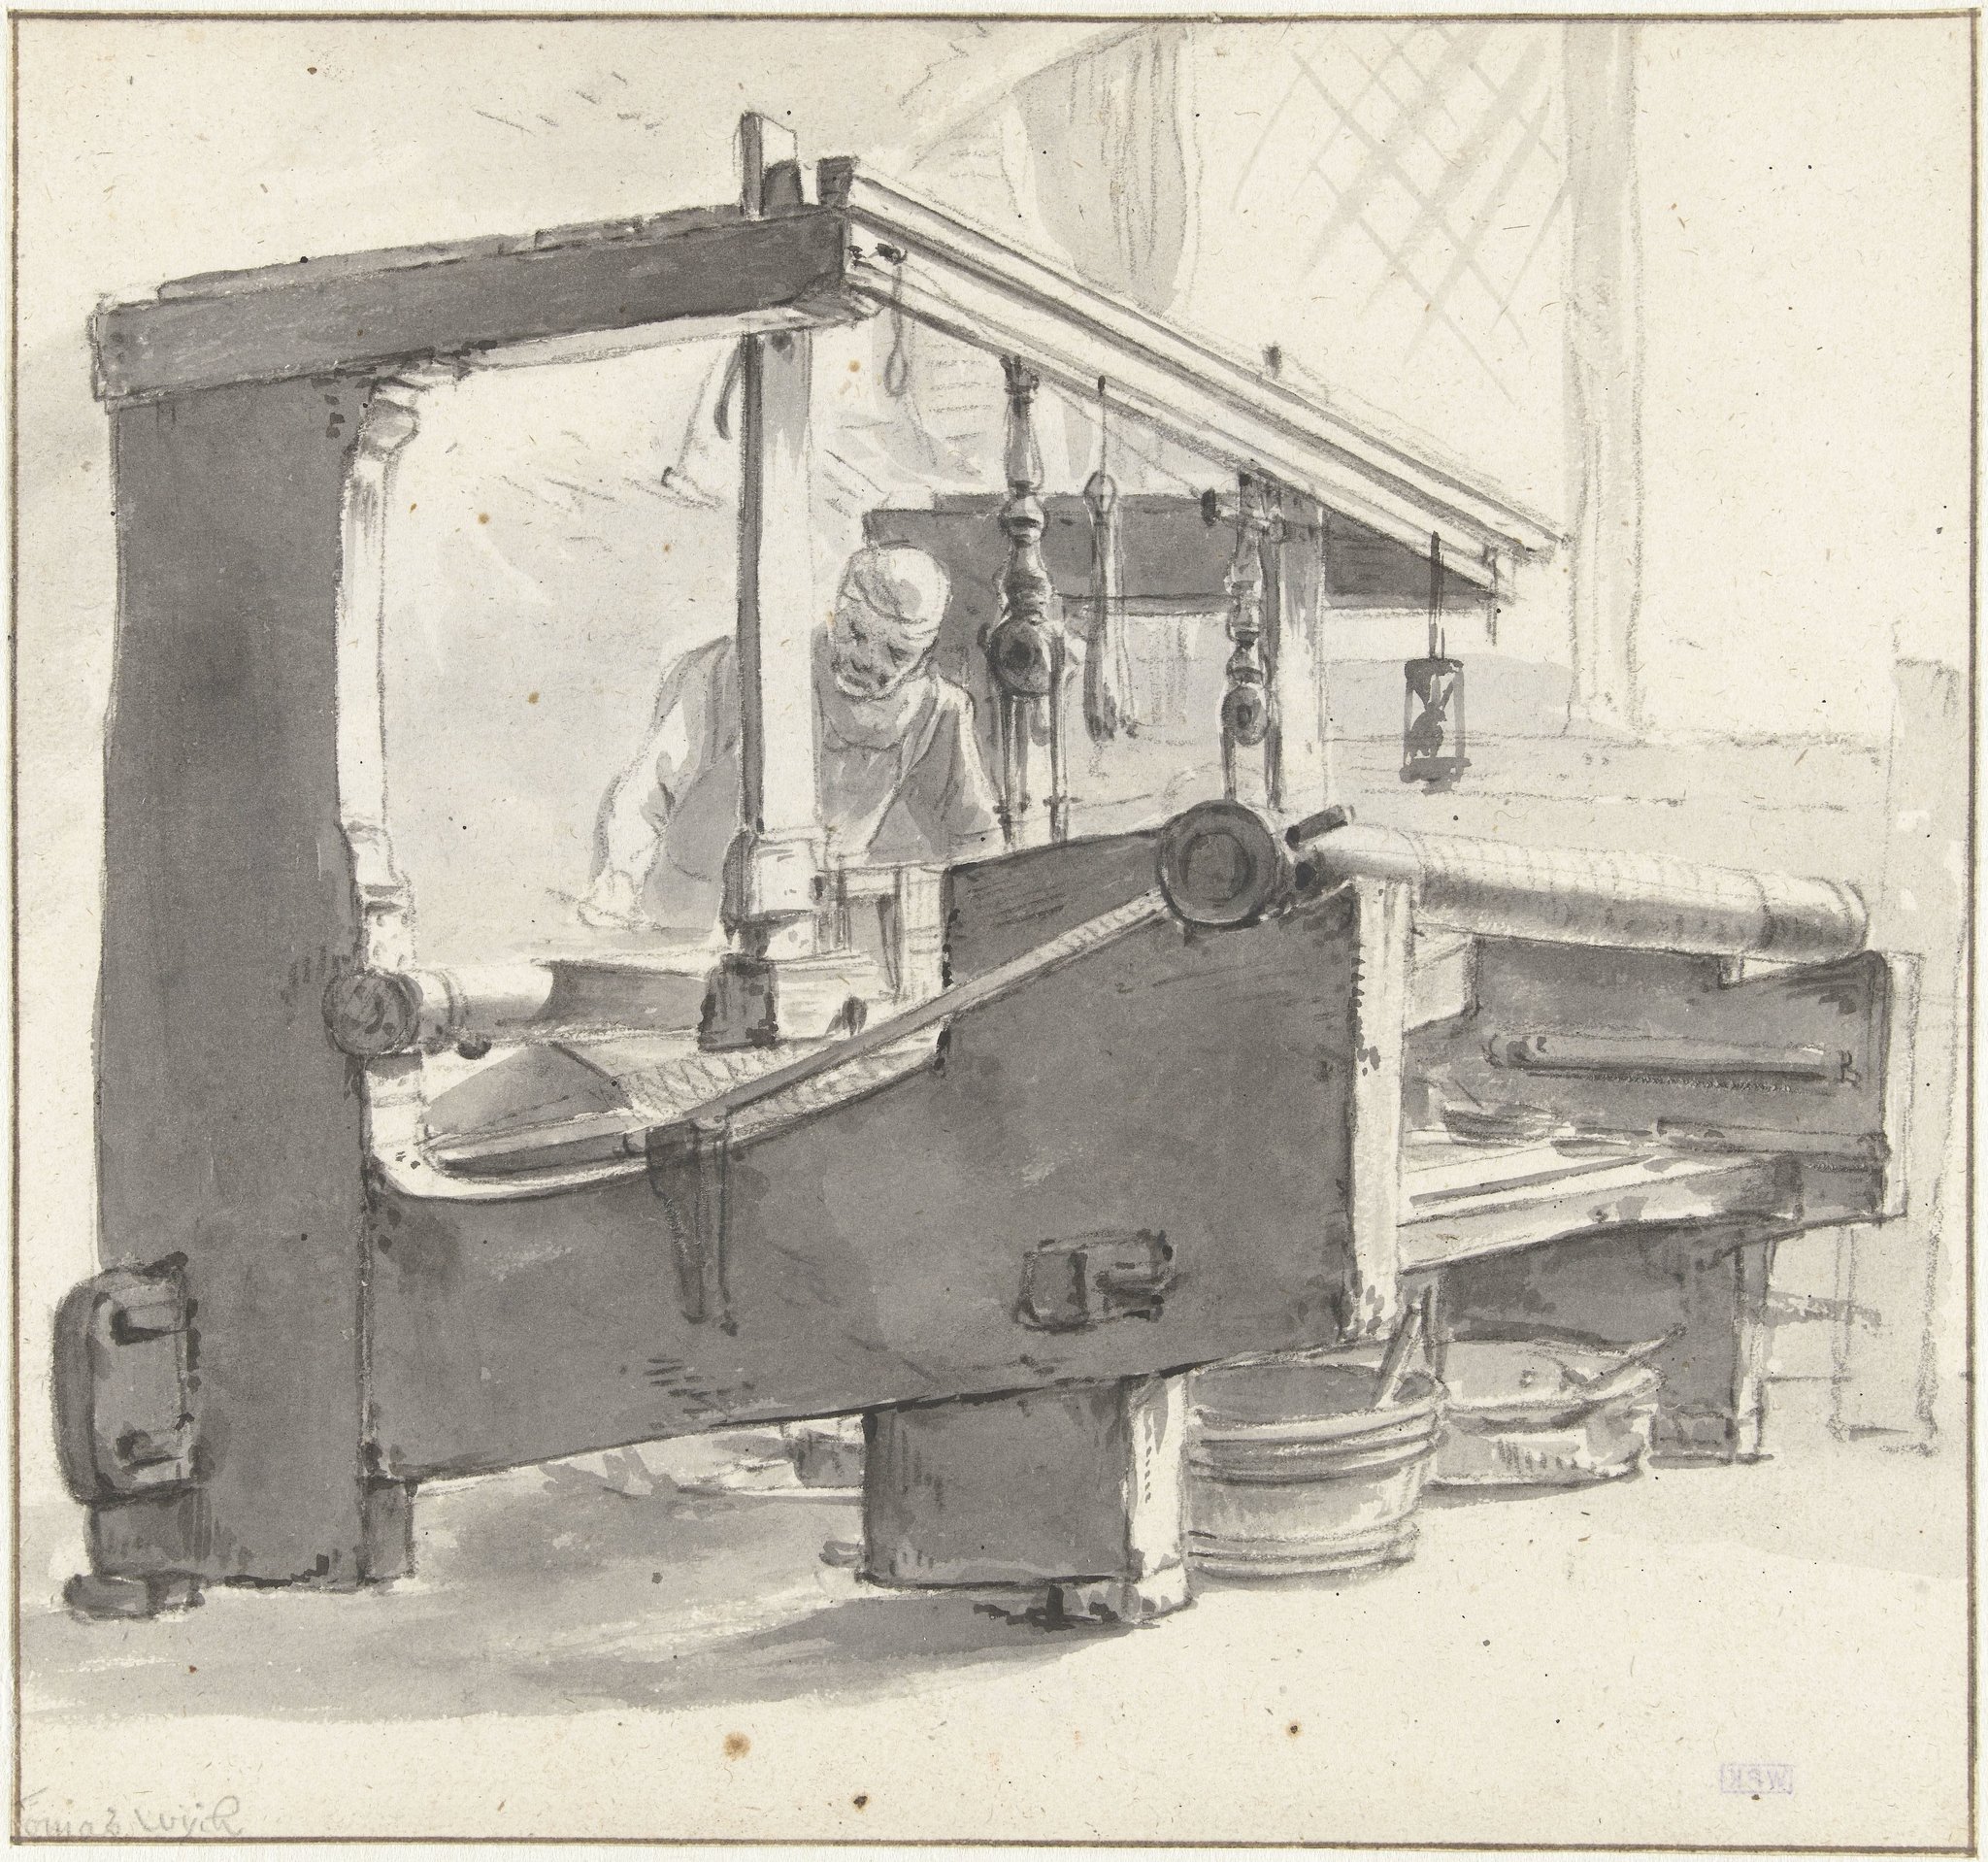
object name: drawing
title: Een wever aan het werk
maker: thomas wijck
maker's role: draughtsman, painter, print maker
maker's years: 1616-1677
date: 1626-1677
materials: chalk, paper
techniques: brush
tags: weaving-loom, weaving